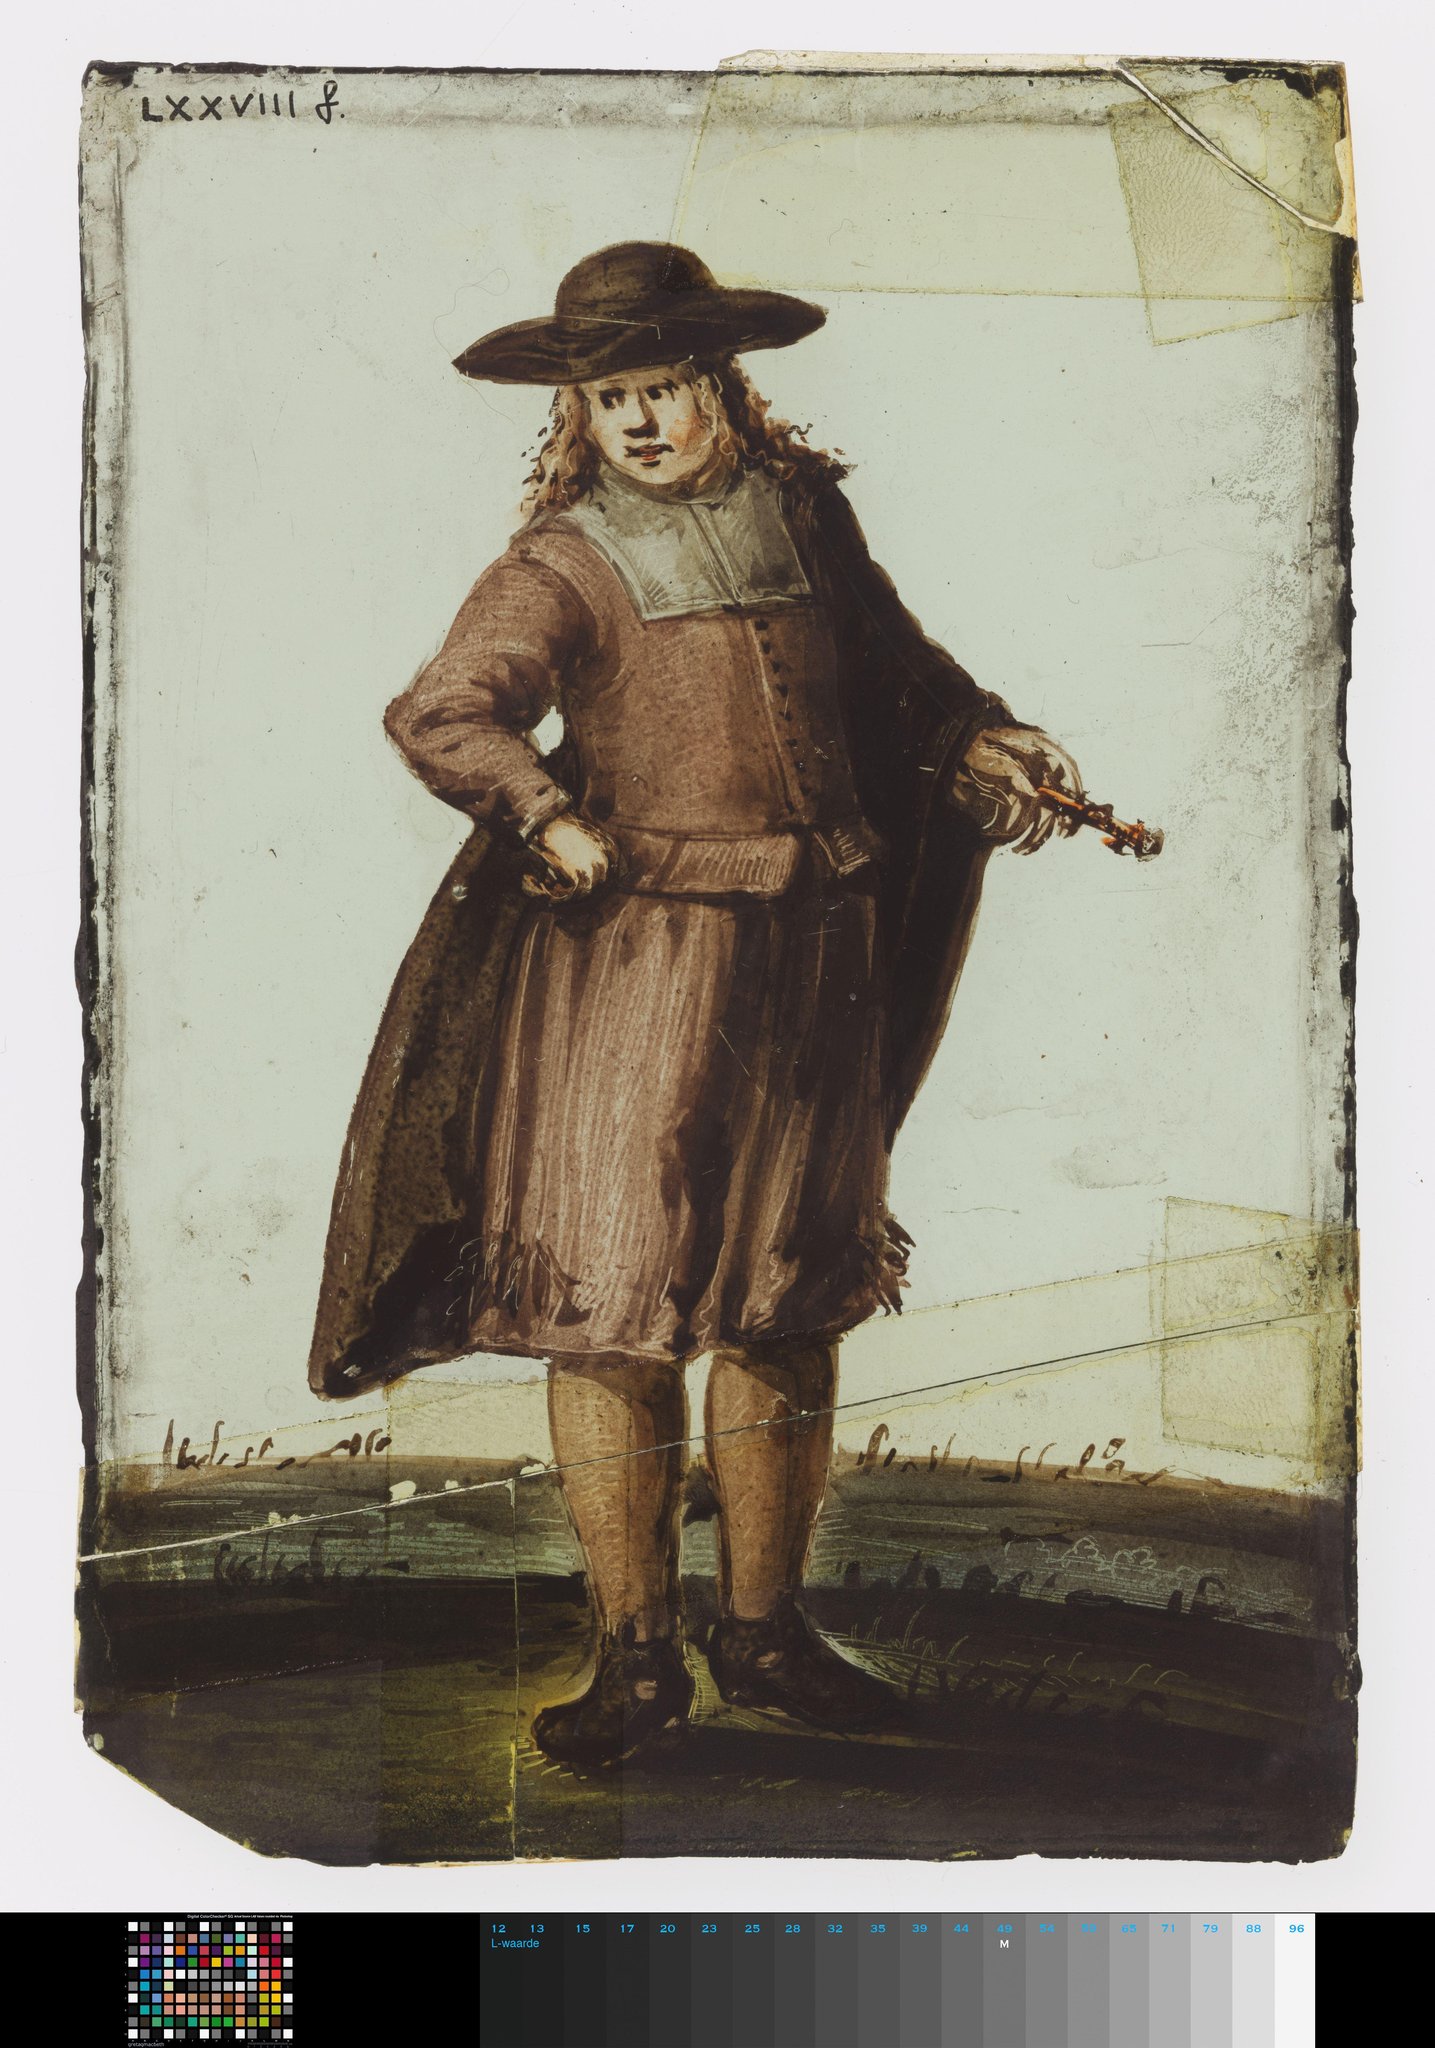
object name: light window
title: Ruit met jongeman in landschap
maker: Anonymous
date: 1650-1675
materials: glass, lead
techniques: enamel painting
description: Een gebrandschilderd ruit met de afbeelding van een deftige jongeman staande in een landschap, gekleurd.